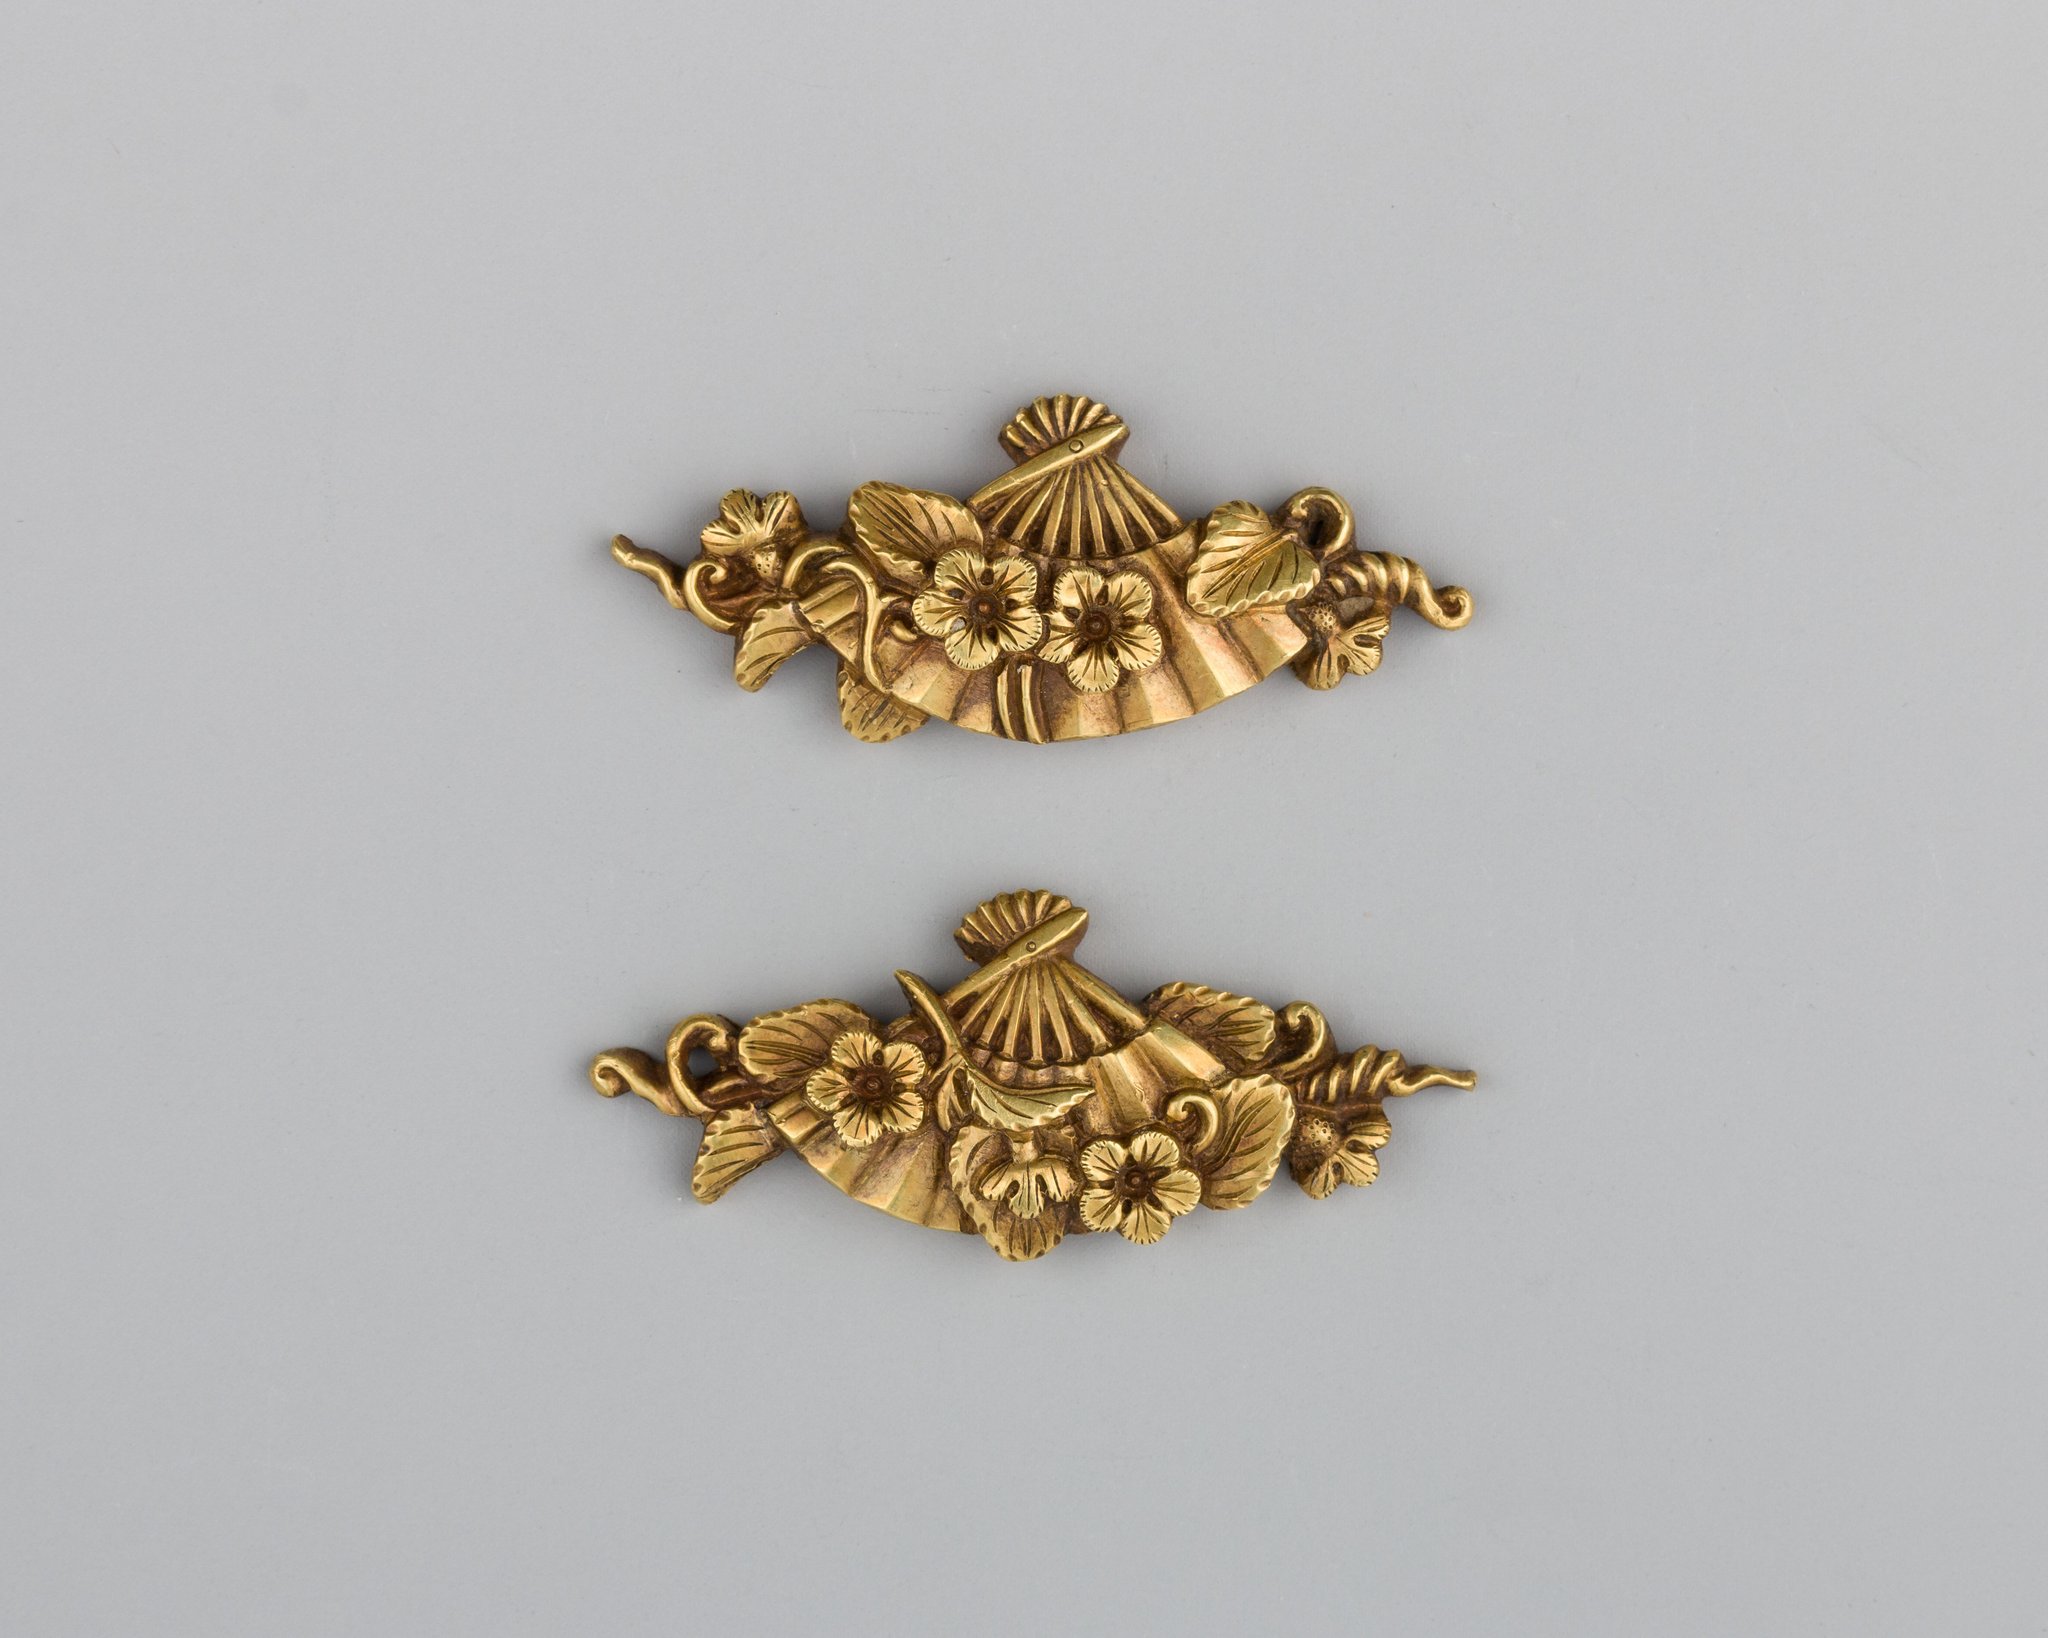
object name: pair of sword grip ornament menuki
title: Pair of Sword-Grip Ornaments (Menuki)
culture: japanese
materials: gold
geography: japan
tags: fans,flowers